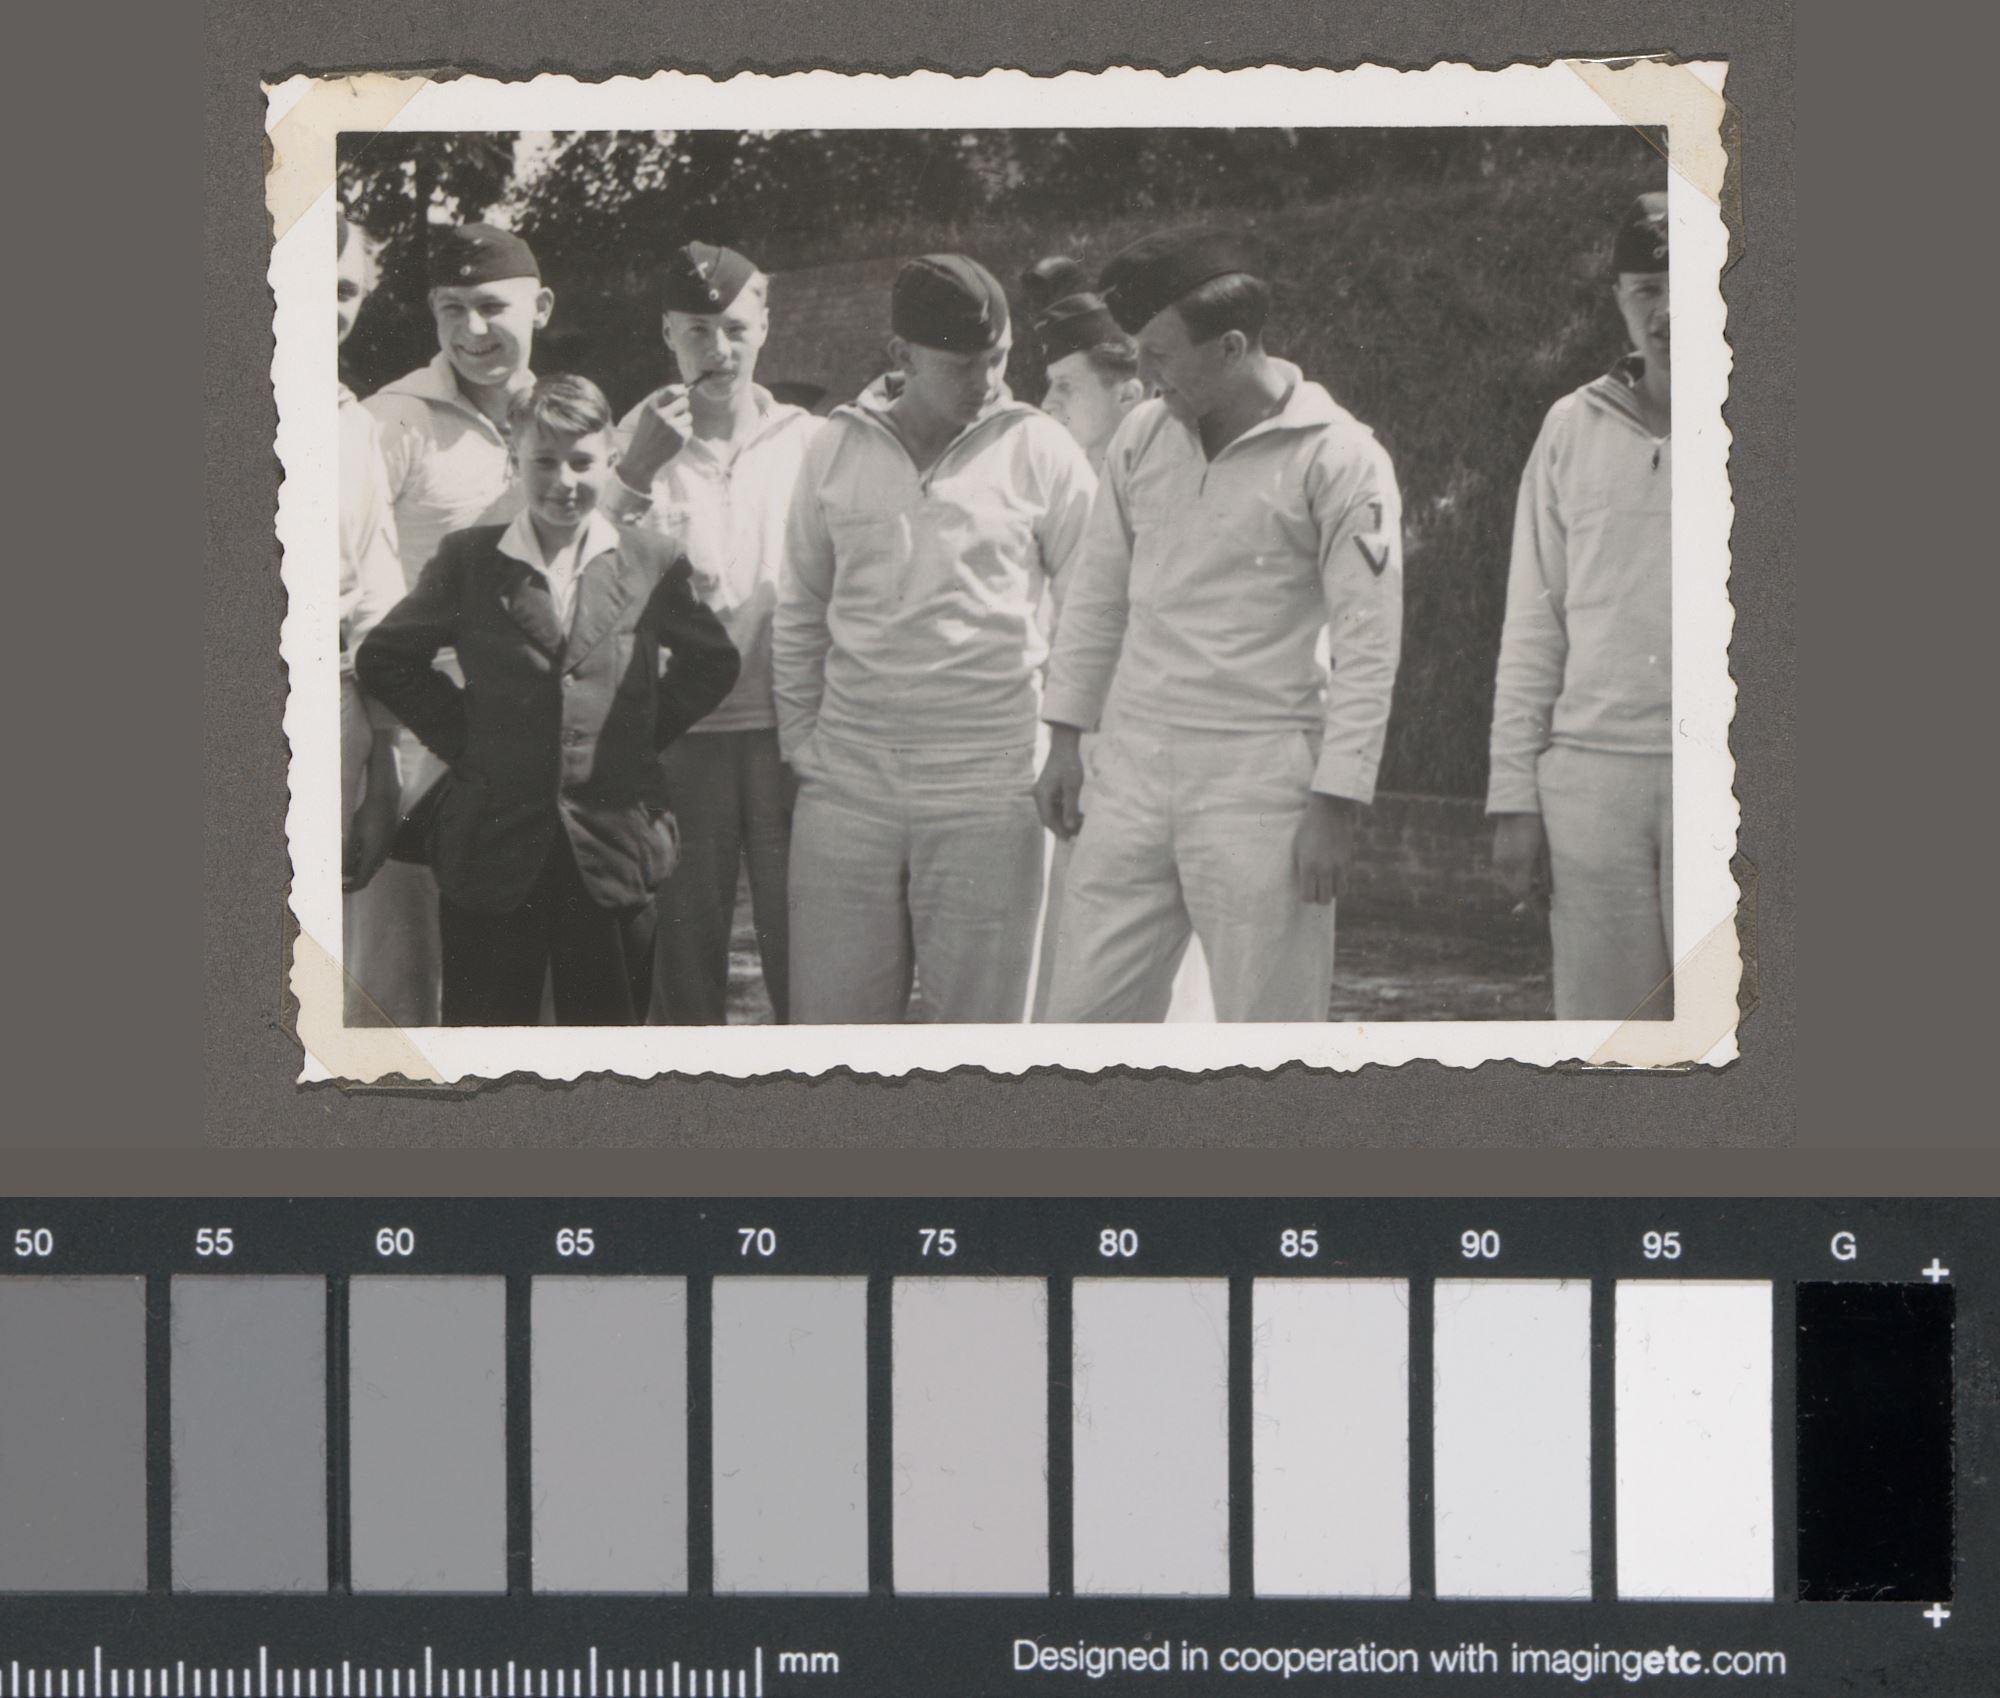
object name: photograph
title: Groepsportret van militairen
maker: Anonymous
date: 1941-1945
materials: paper, photographic support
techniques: gelatin silver print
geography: netherlands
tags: the soldier; the soldier's life, occupation ~ war, netherlands